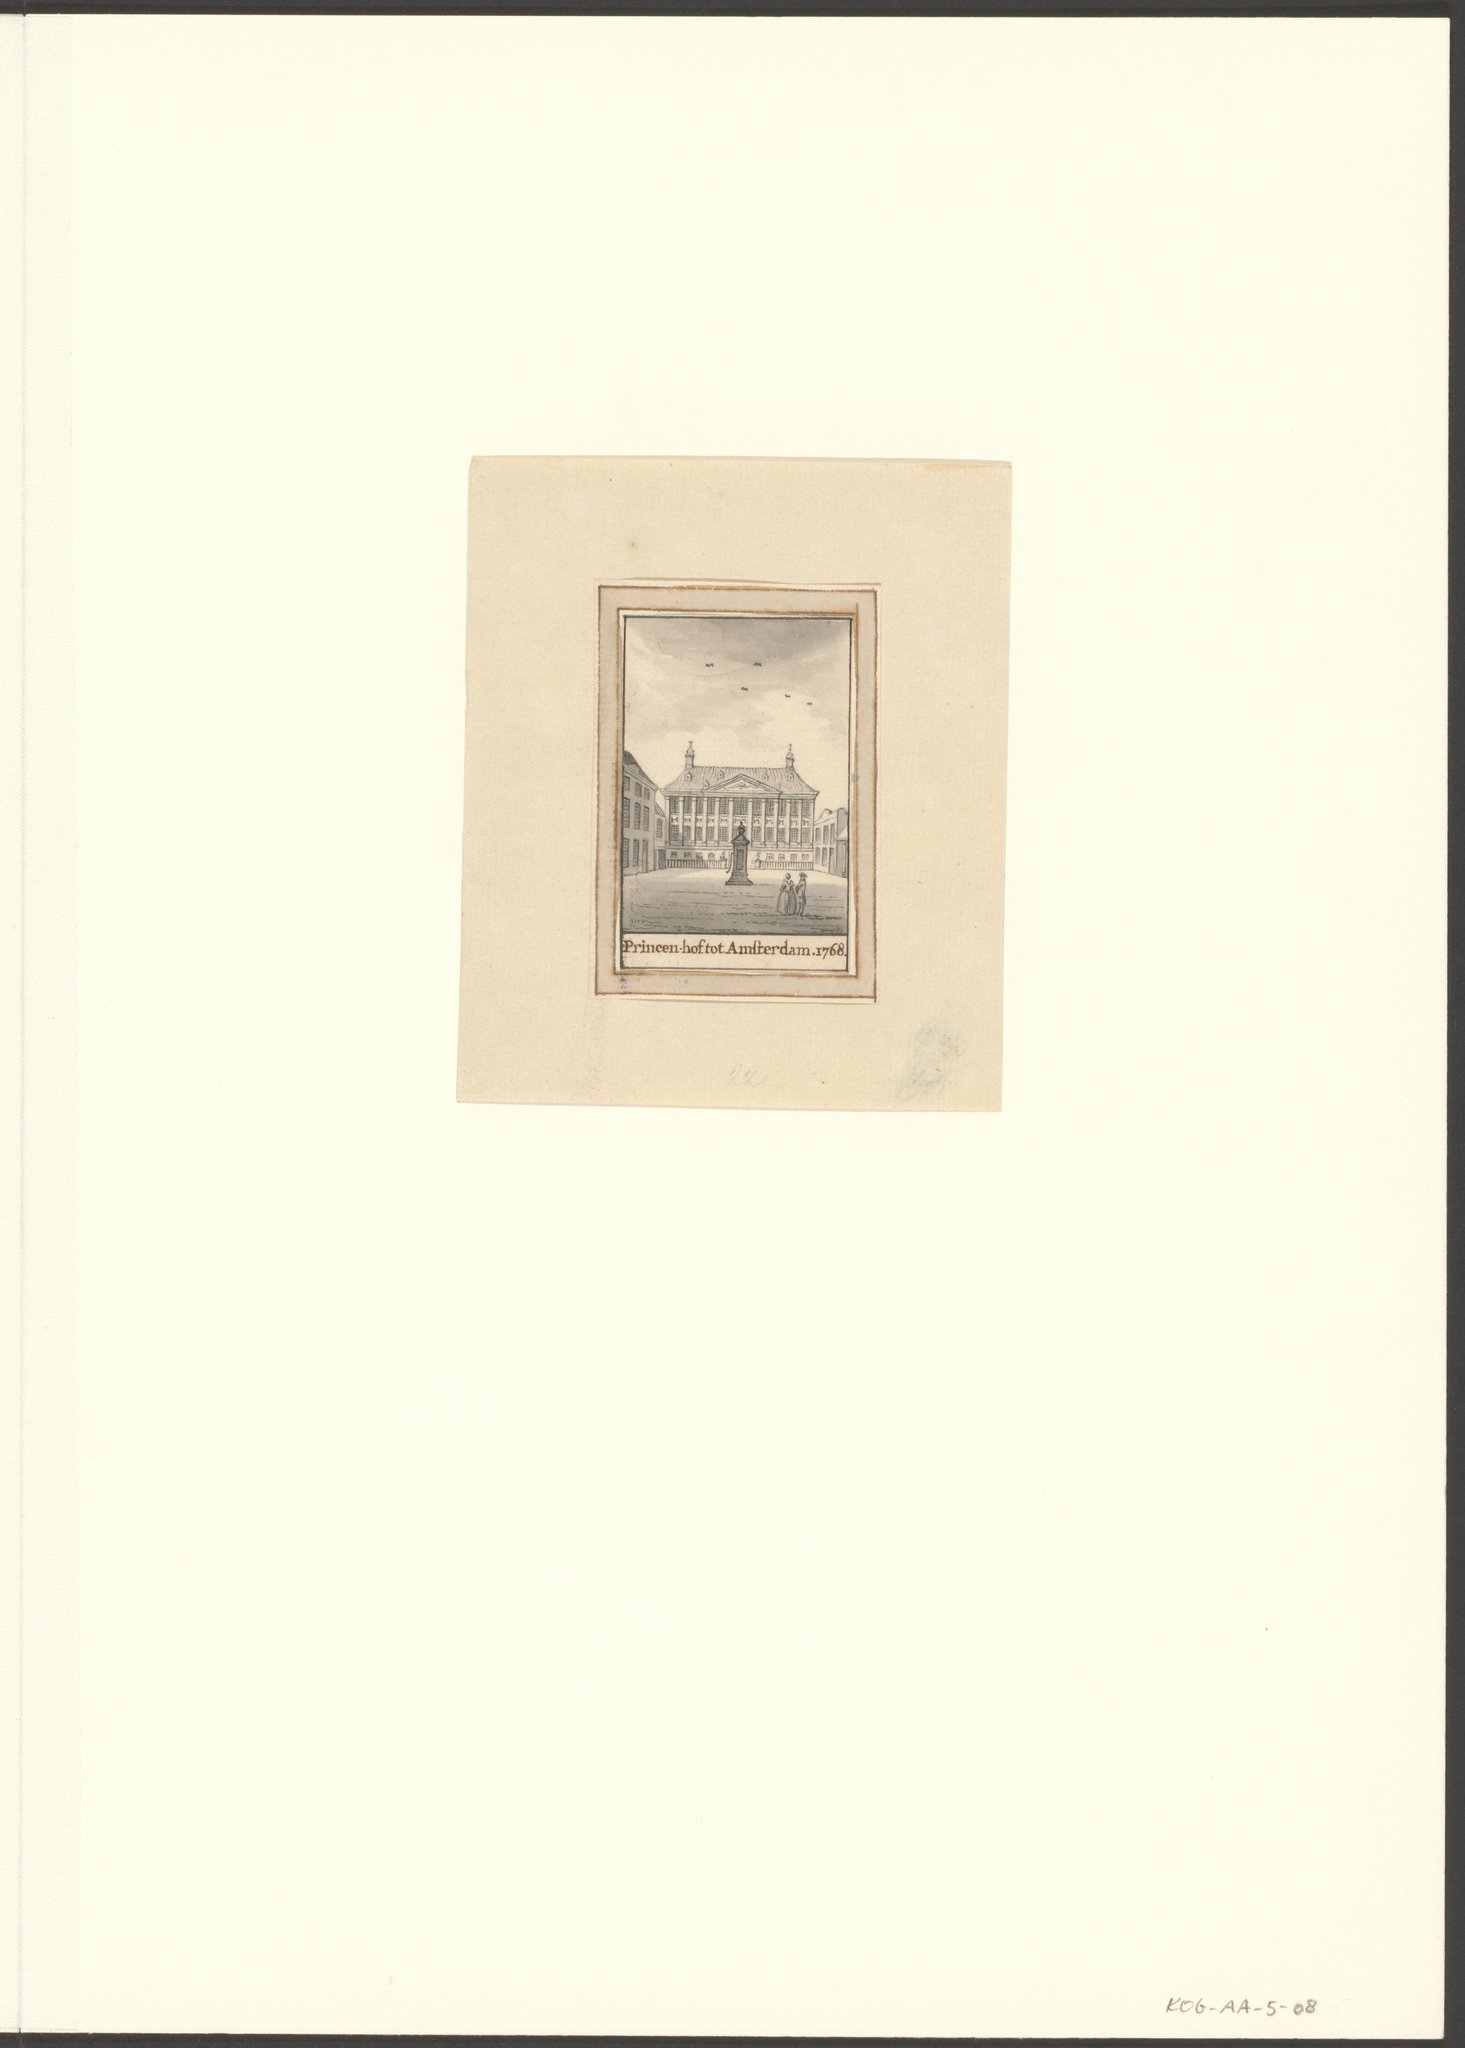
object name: drawing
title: Gezicht op het Prinsenhof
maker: Anonymous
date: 1768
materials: ink, paper, pencil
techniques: brush, pen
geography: amsterdam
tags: city-view in general; 'veduta', façade (of house or building)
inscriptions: collector's mark: Lugt 2786a, inscription: ‘Princen-hof tot Amsterdam.1768.’, number: ‘31’